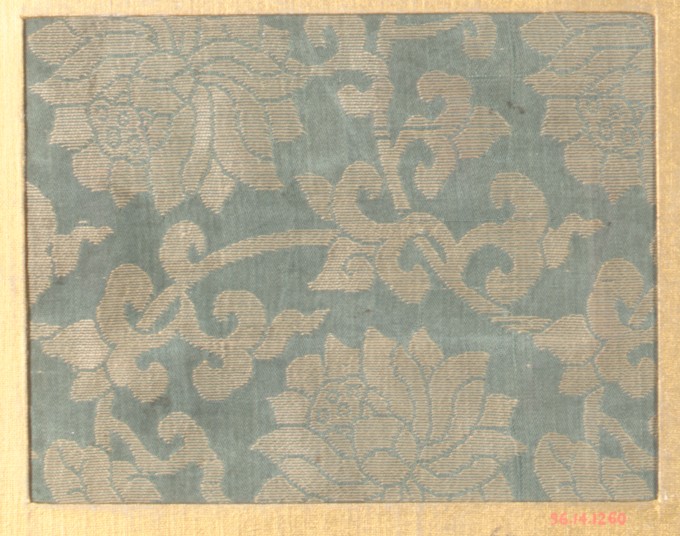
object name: piece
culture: japanese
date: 1701-1900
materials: silk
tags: flowers